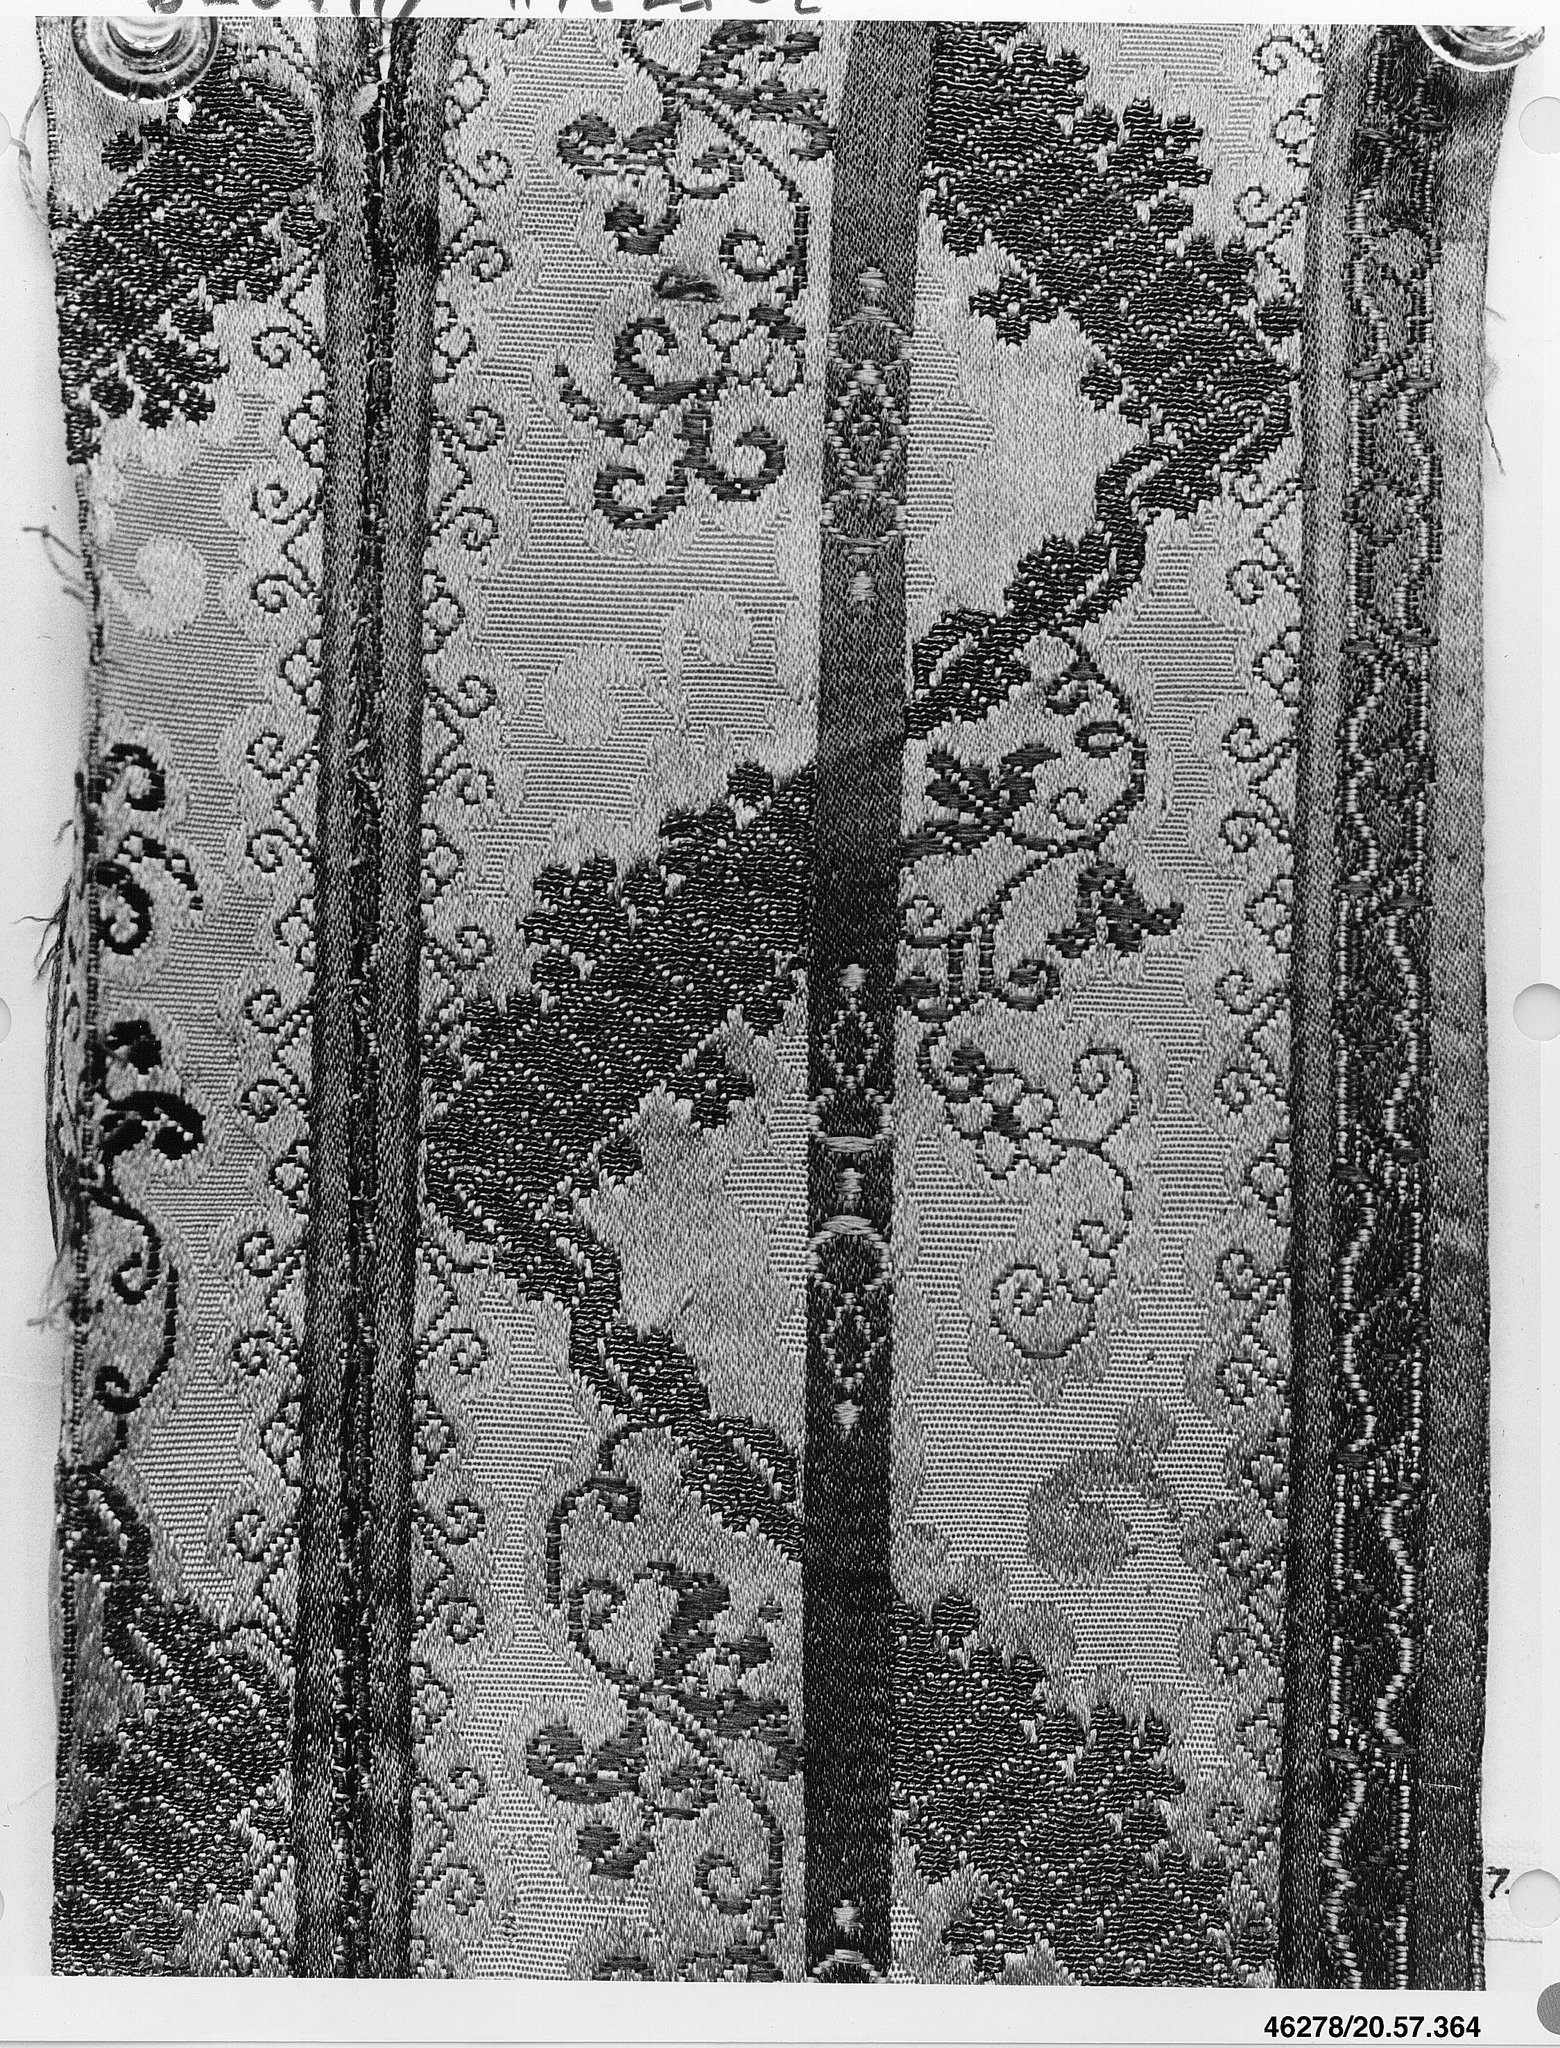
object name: piece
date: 1701-1800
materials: metal thread, silk